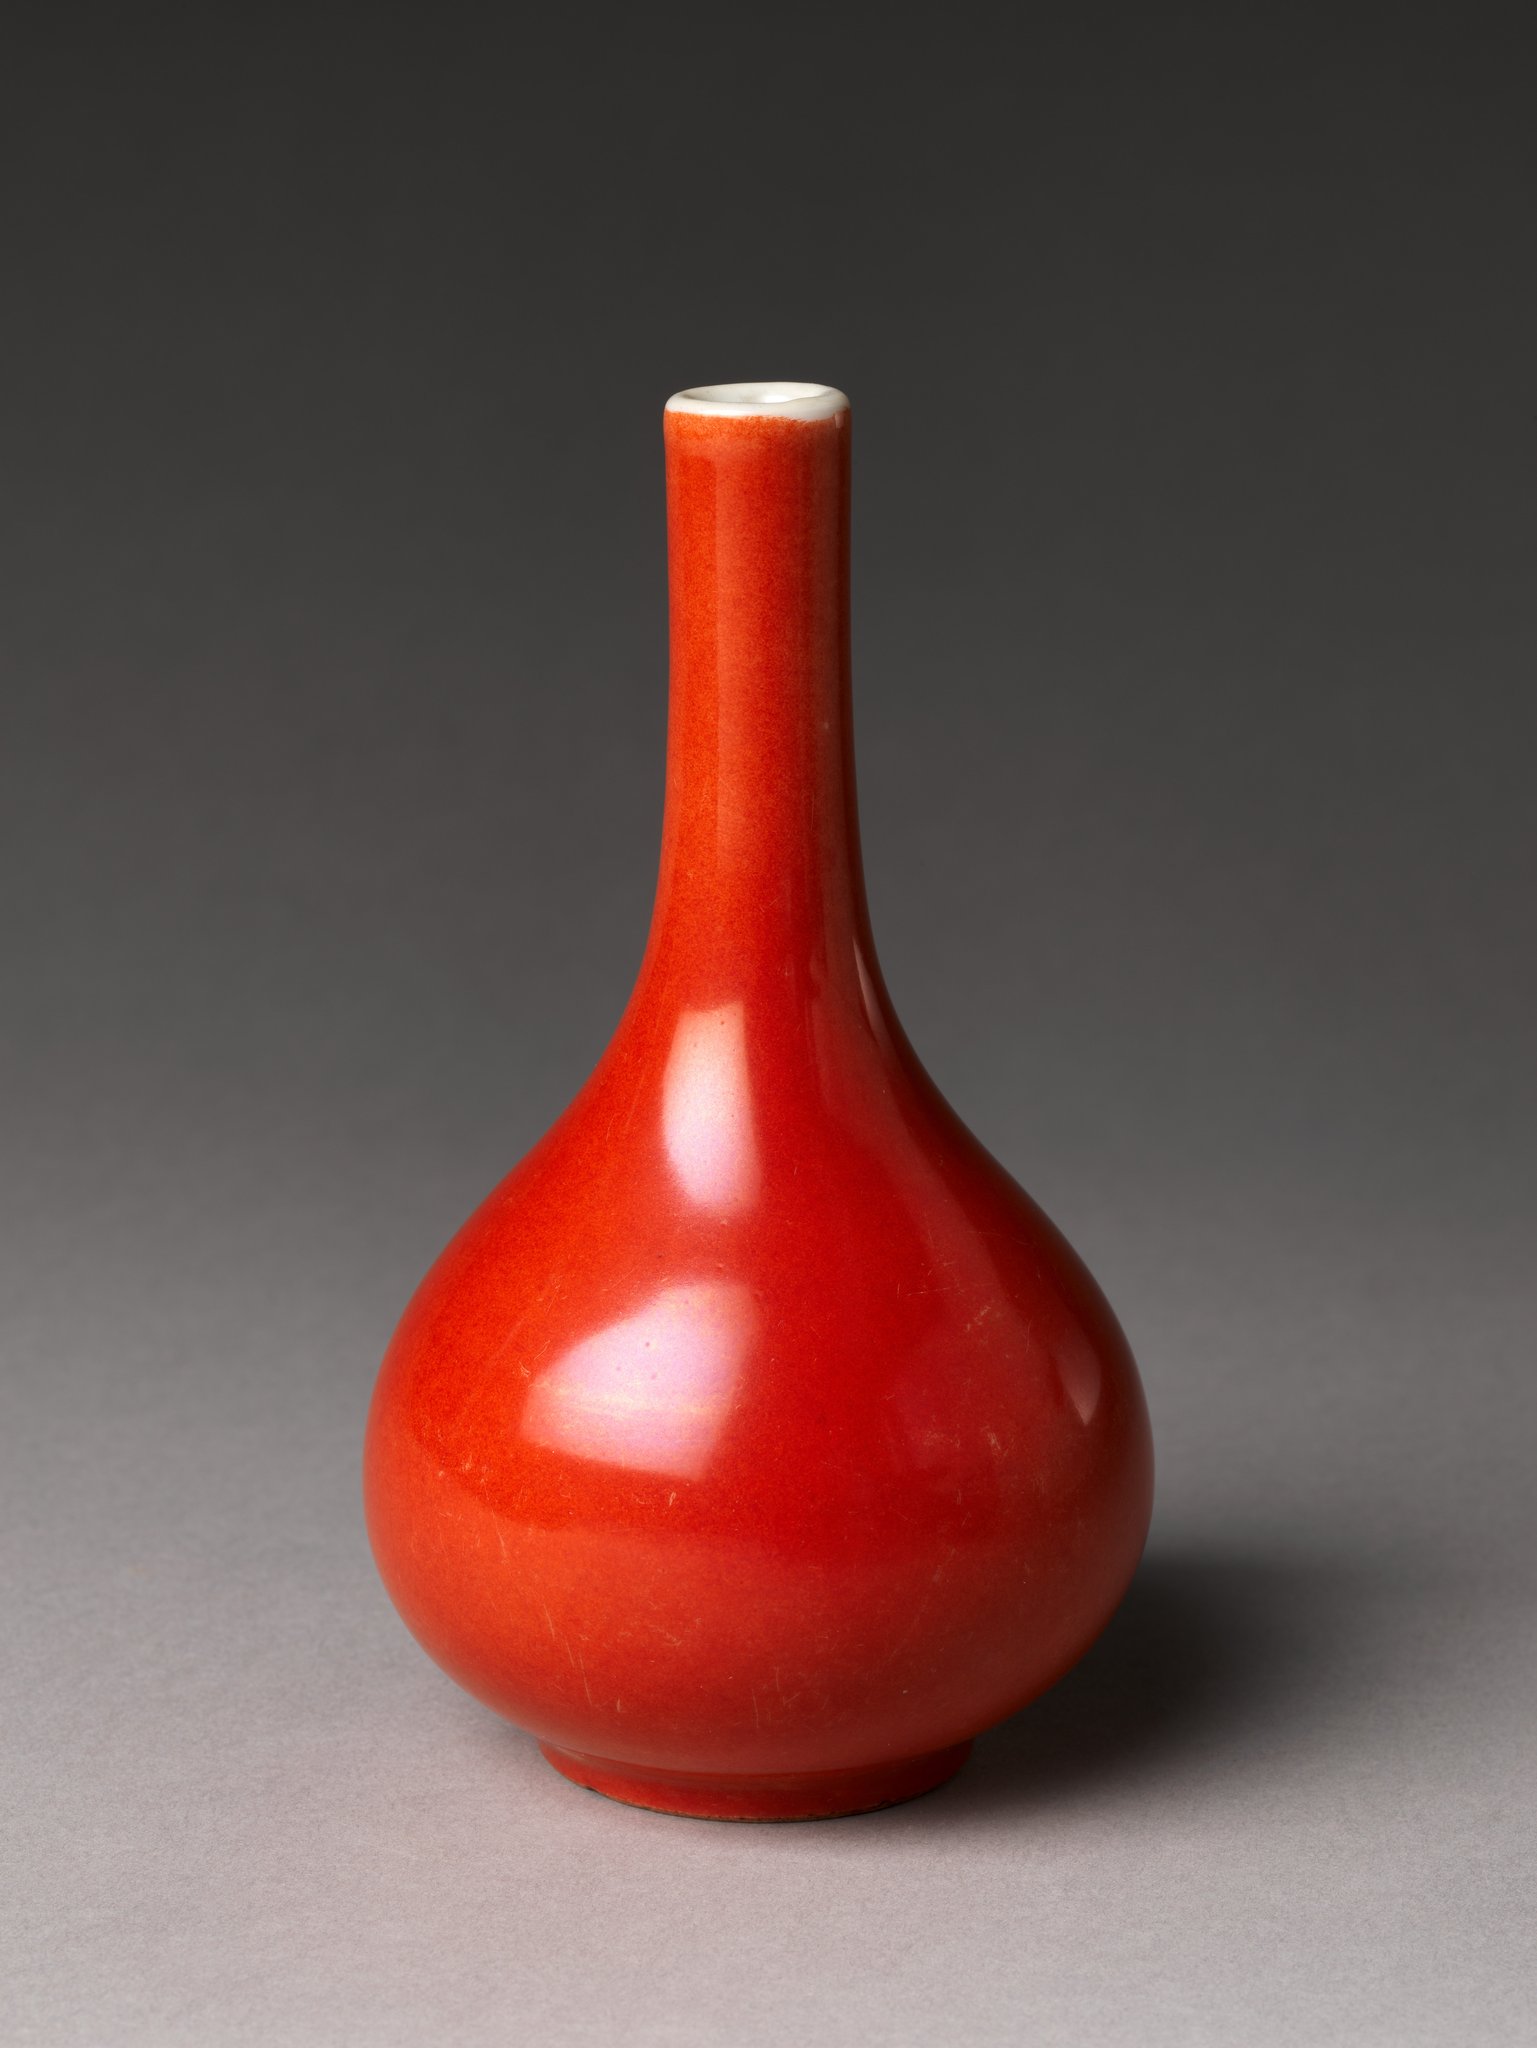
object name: vase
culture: chinese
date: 1801-1900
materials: coral, glaze, porcelain